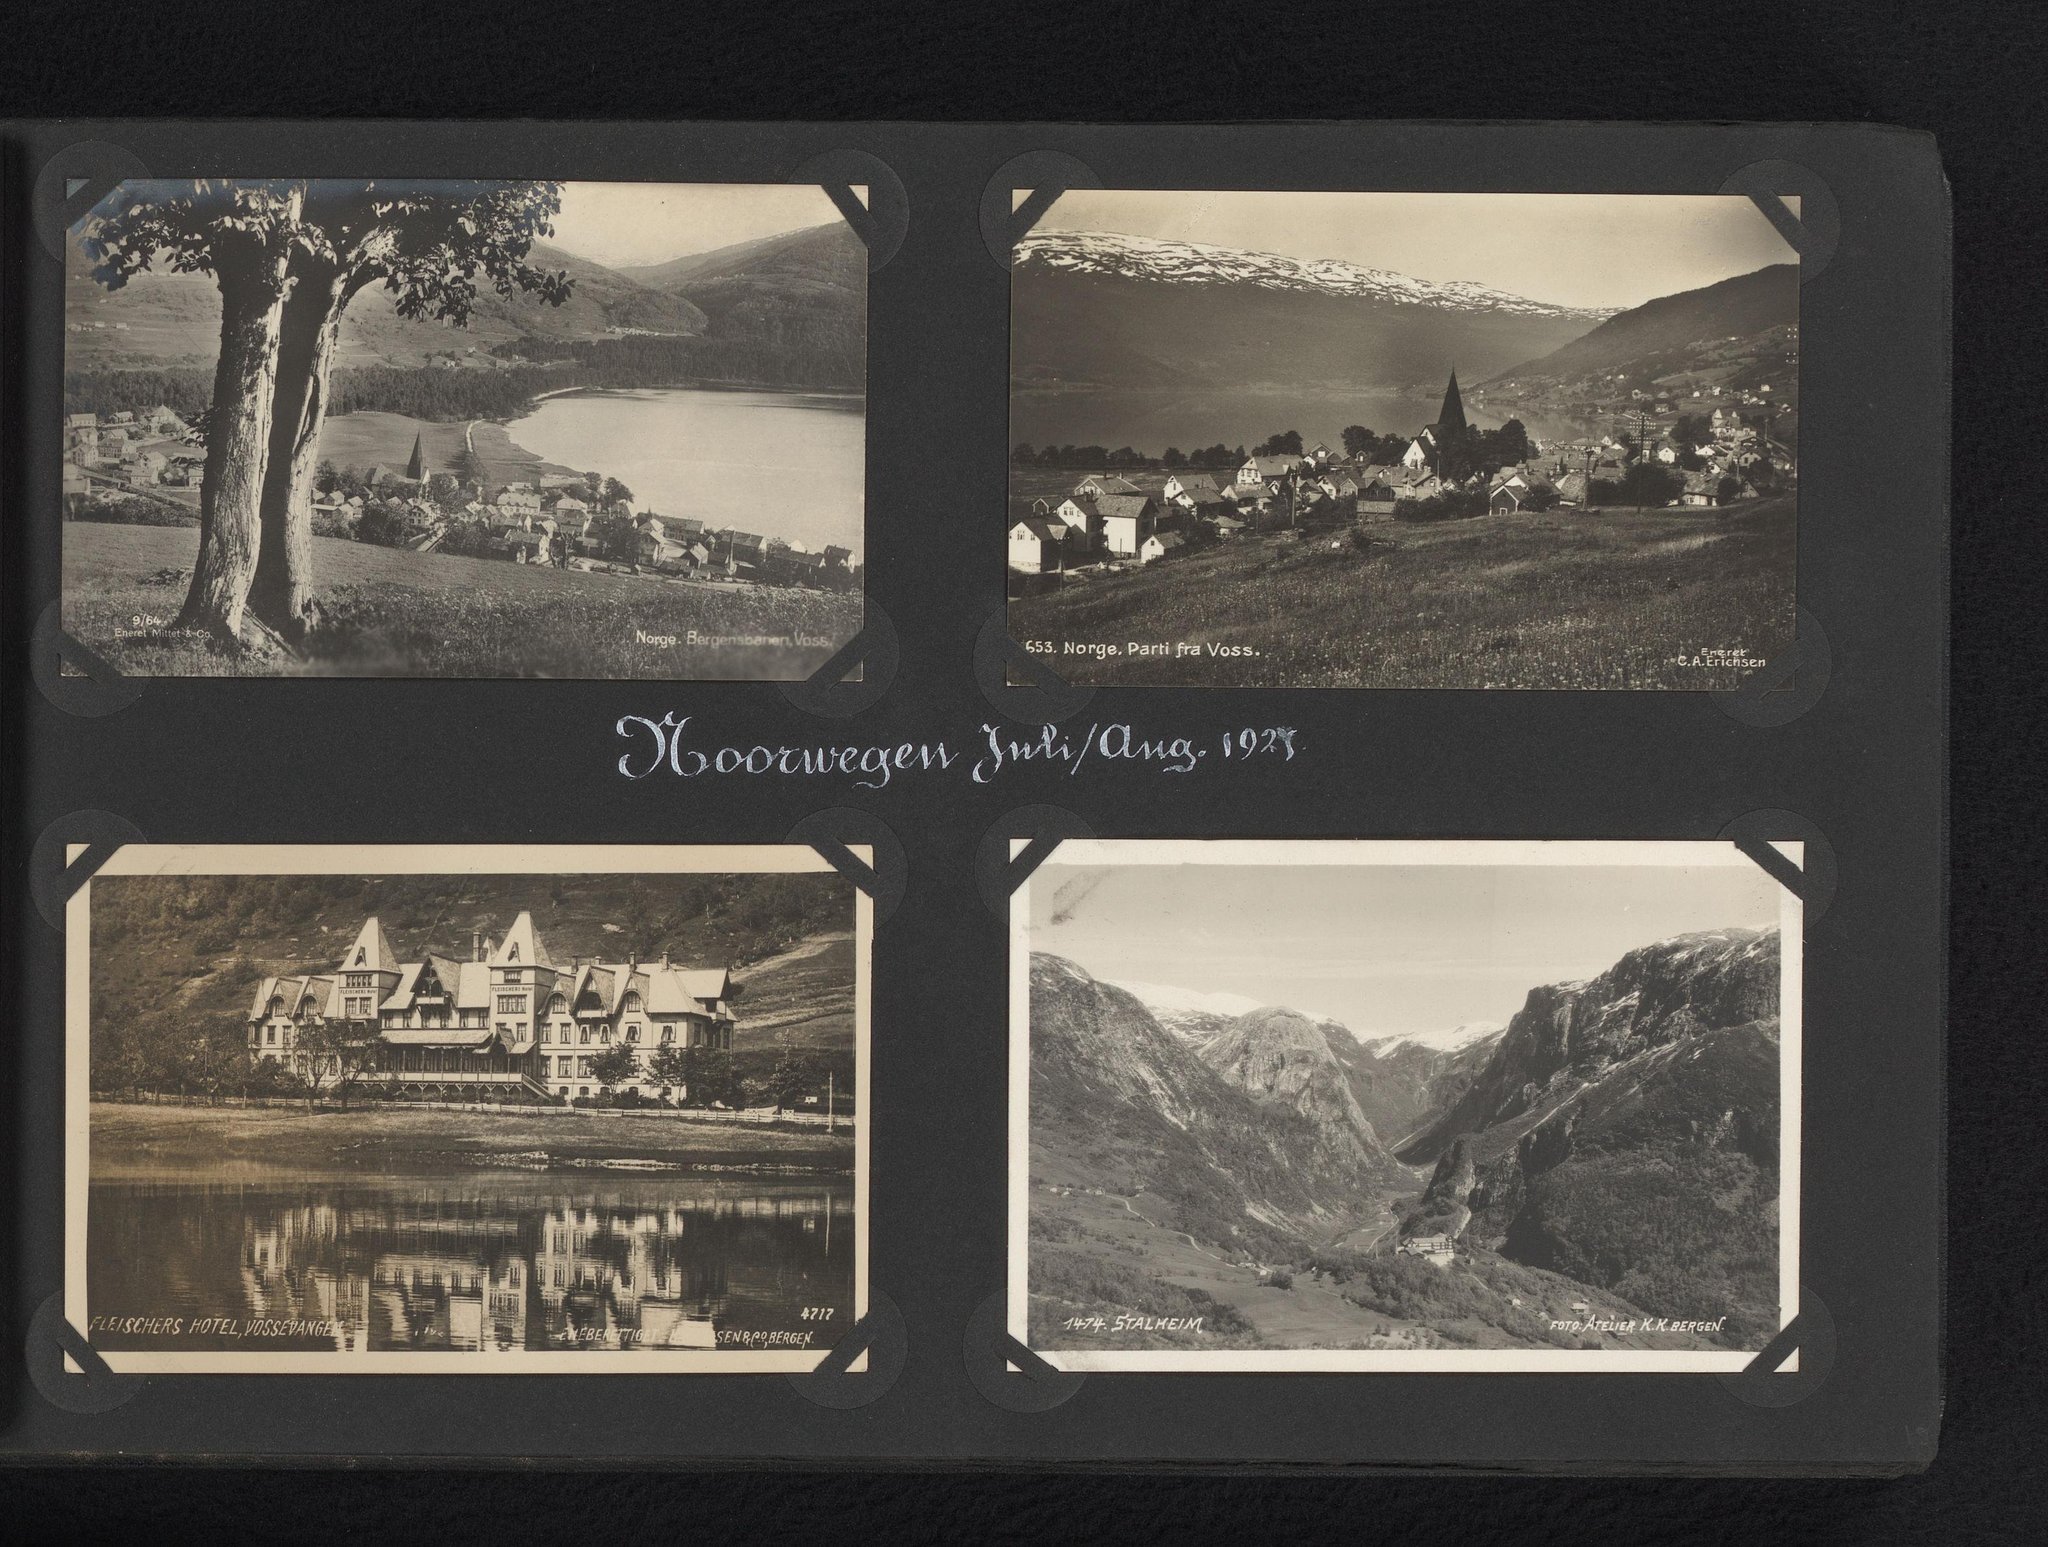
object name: photograph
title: Vier fotografische prentbriefkaarten van de omgeving van Voss en Stalheim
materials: paper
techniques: gelatin silver print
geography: norway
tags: village, hotel, hostelry, inn, mountains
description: Deze foto's maken deel uit van een album.